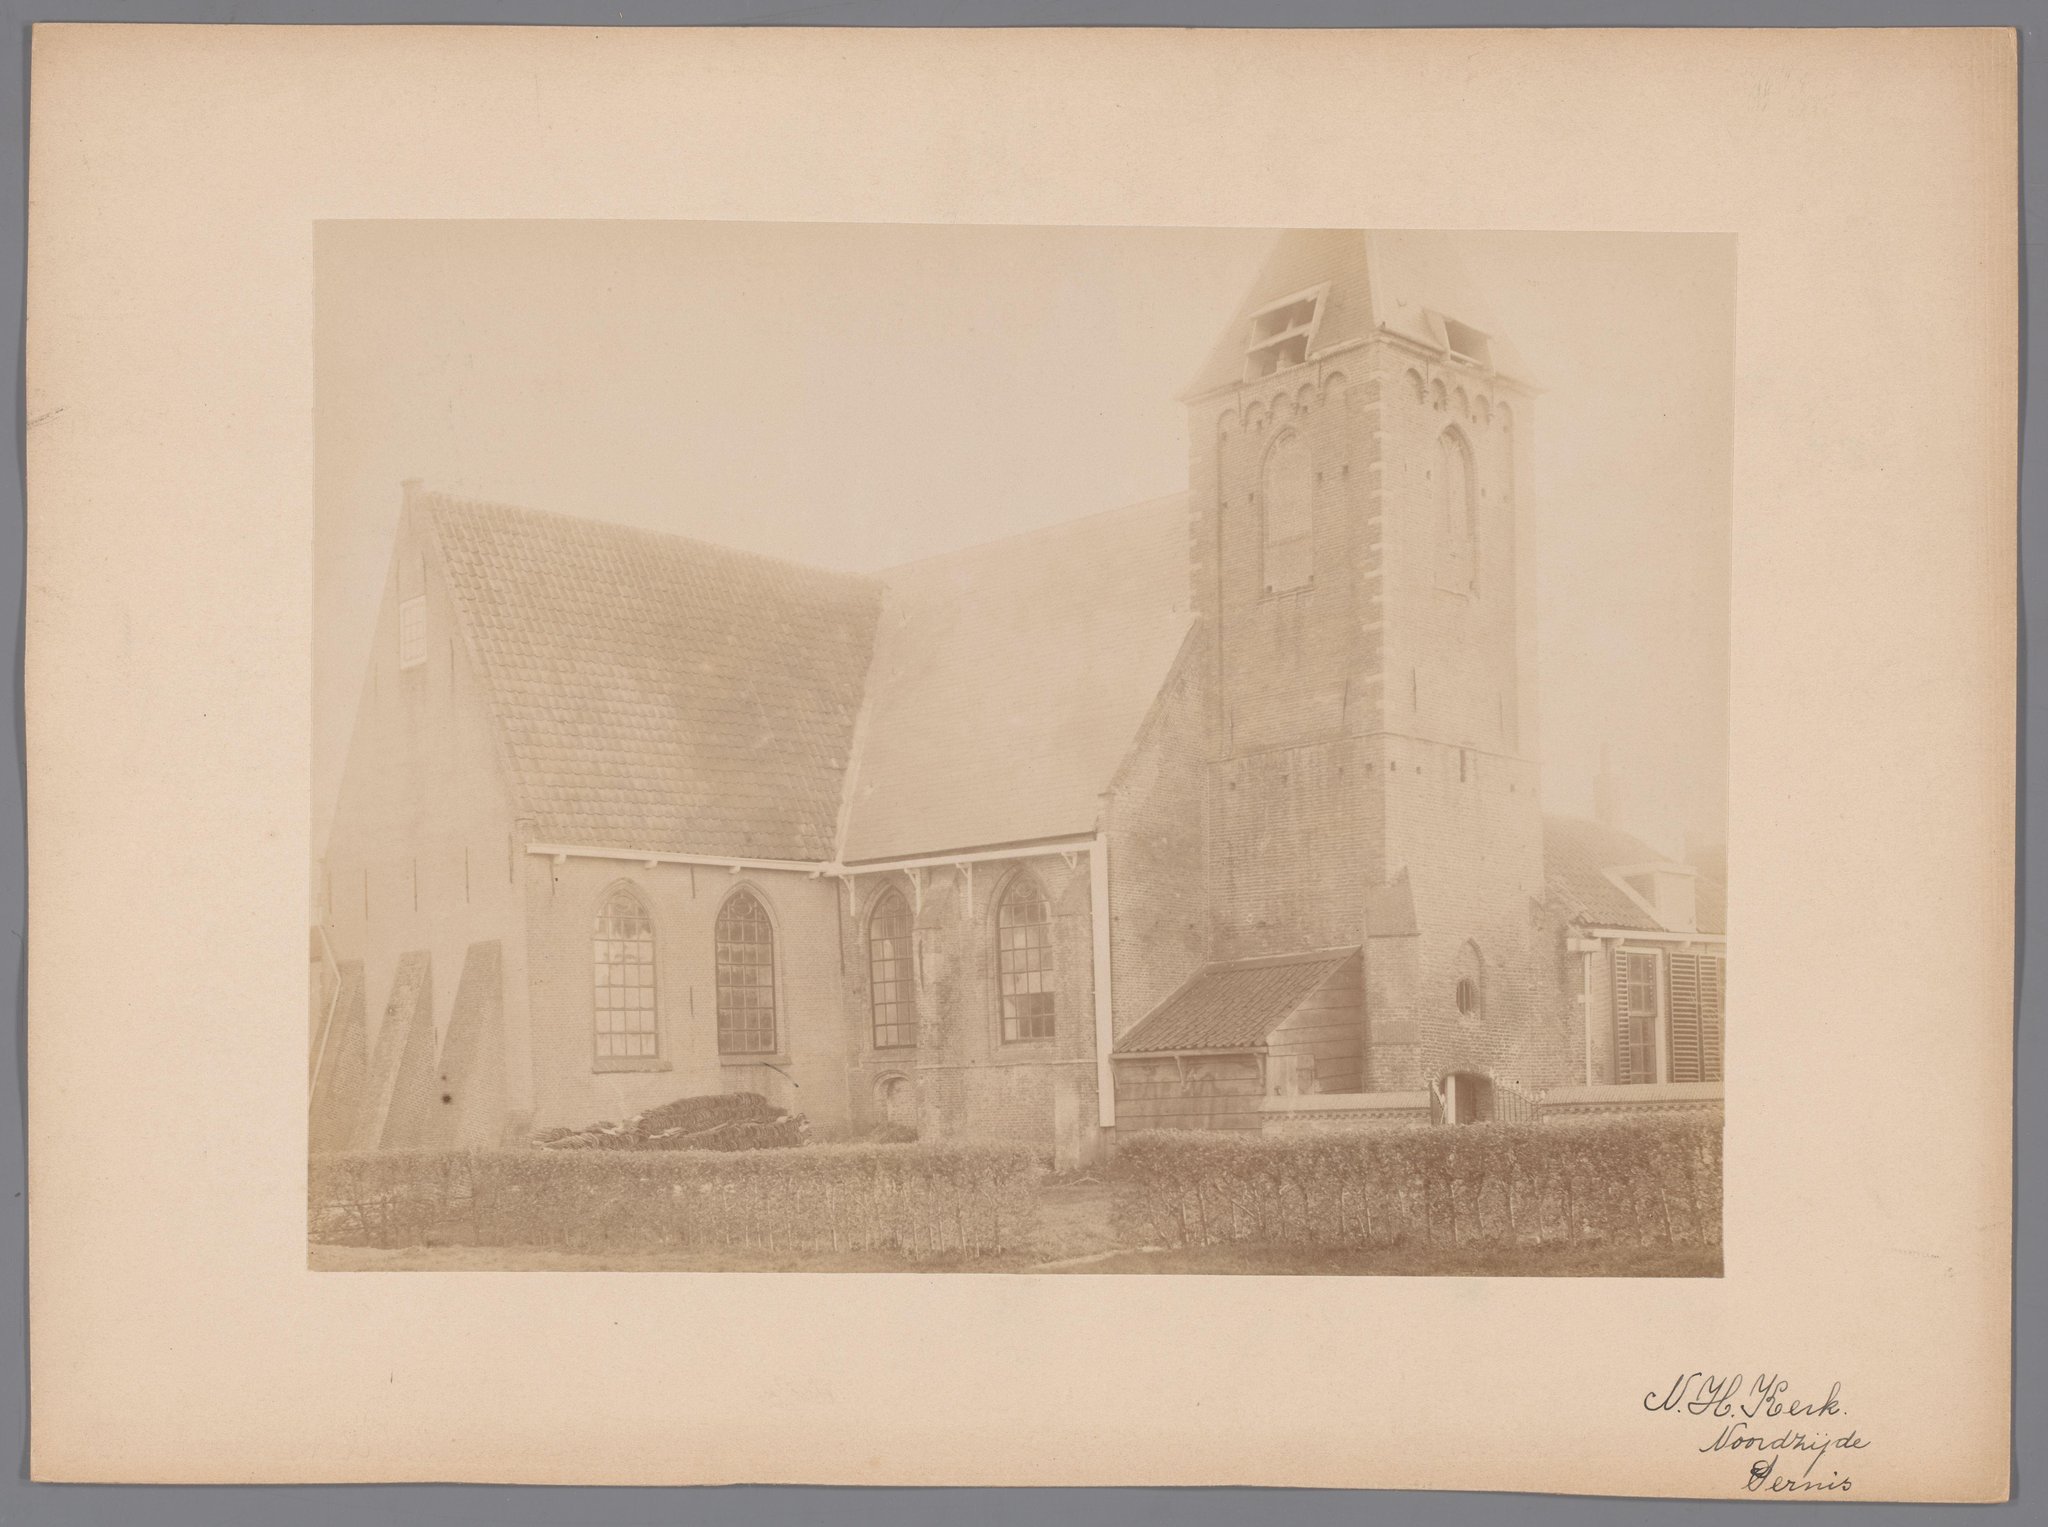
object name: photograph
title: Noordzijde van de Hervormde Kerk te Pernis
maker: anoniem (monumentenzorg)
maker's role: fotograaf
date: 1890-1920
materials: cardboard, photographic support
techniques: albumen print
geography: pernis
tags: church (exterior)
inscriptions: annotation: ‘Pernis/ N.H. Kerk/ N. zijde’, annotation: ‘N.H. Kerk/ Noordzijde/ Pernis’